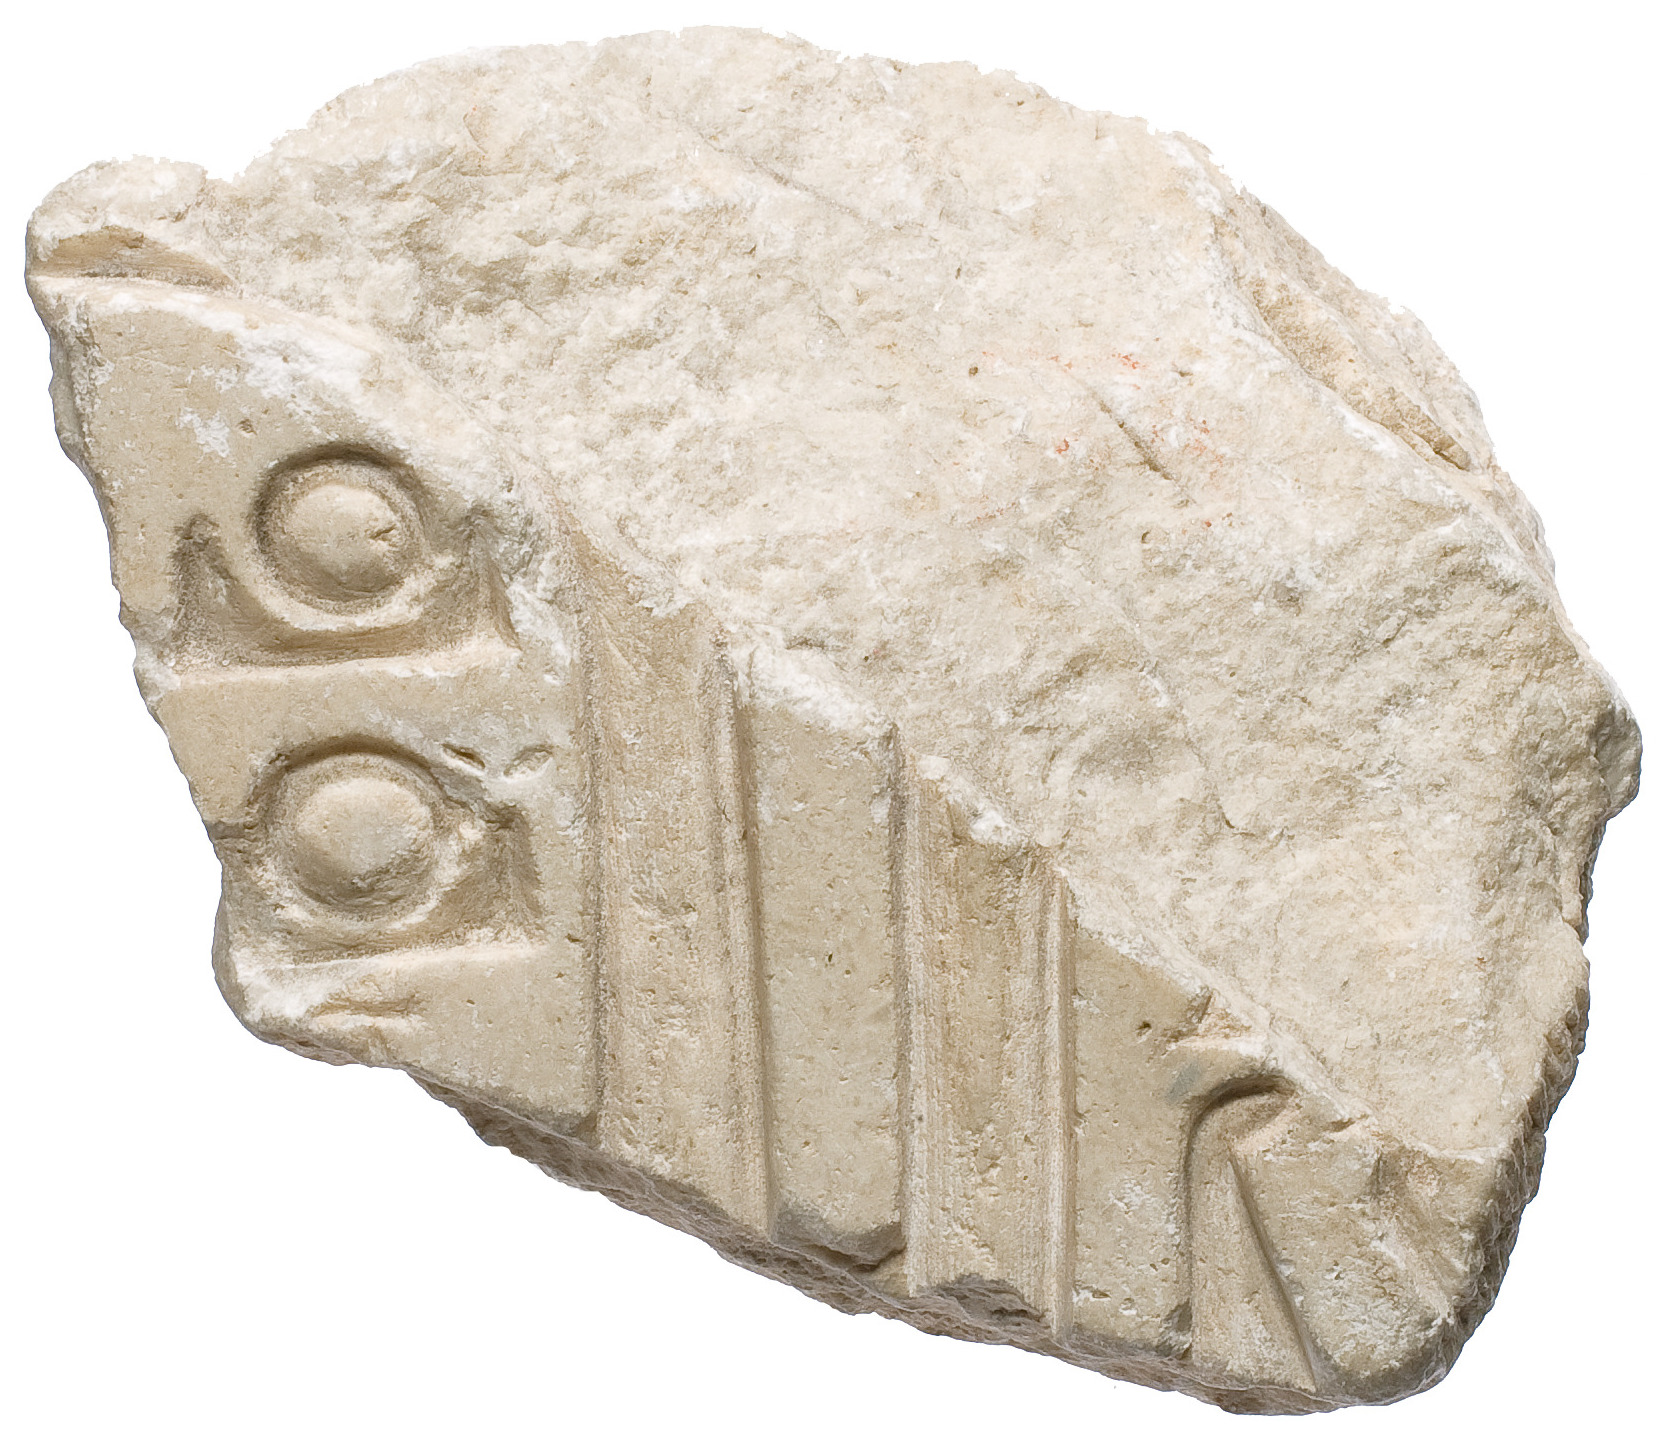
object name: inscribed fragment, aten cartouche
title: Inscribed fragment, Aten cartouches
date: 1353-1336 BCE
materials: limestone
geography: egypt